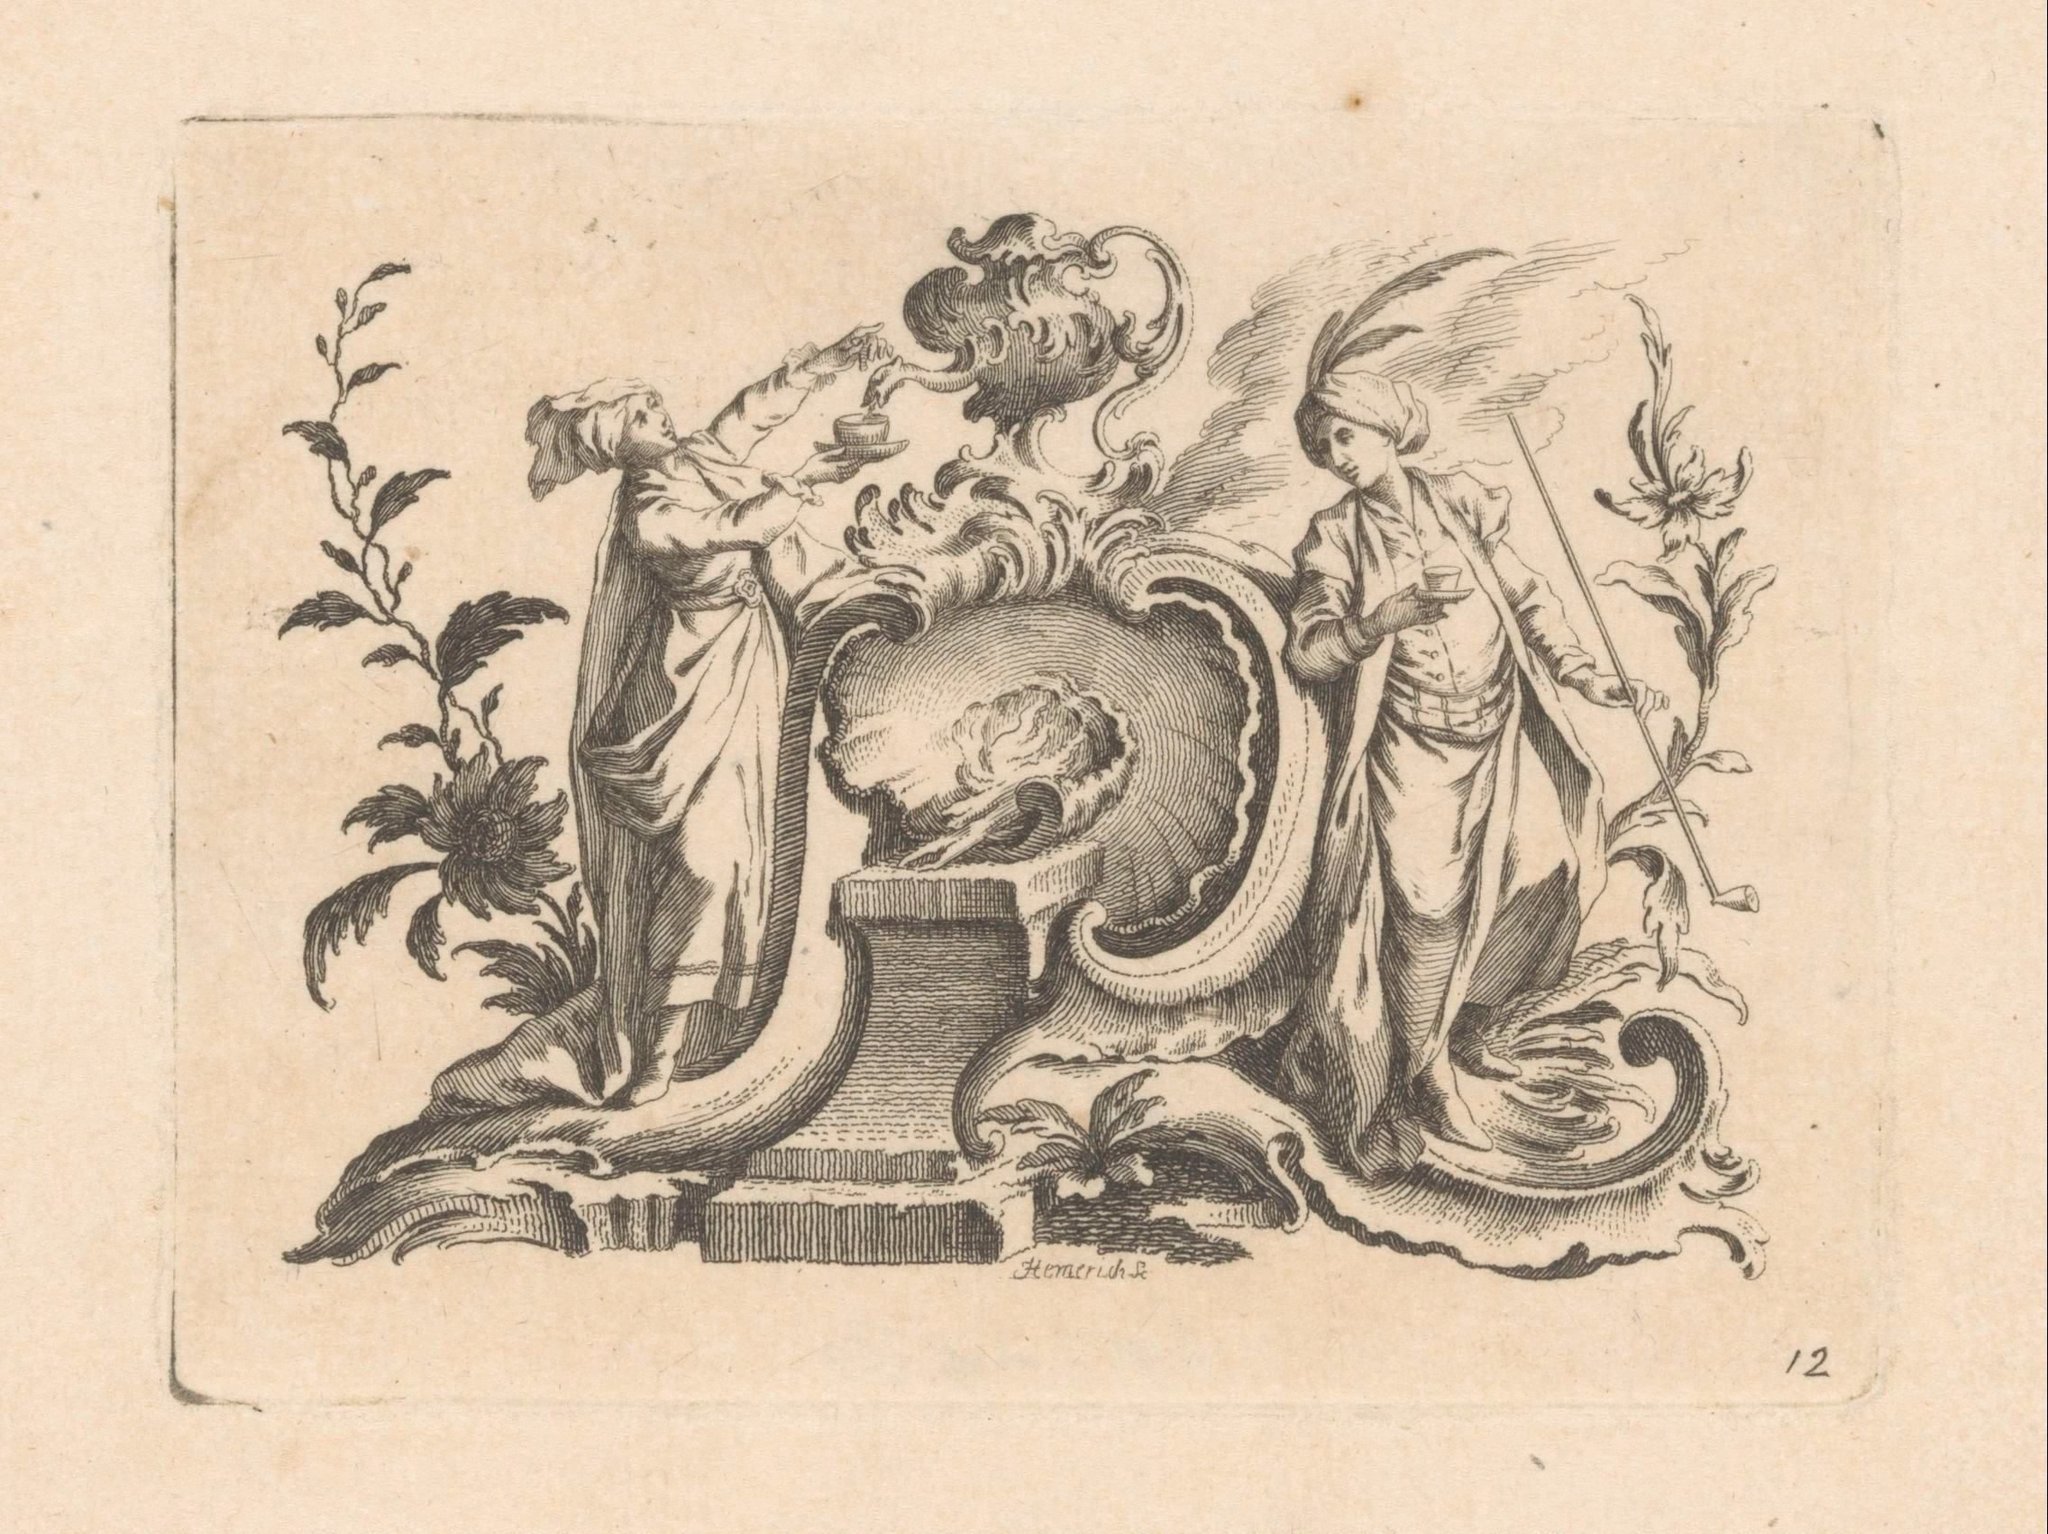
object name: ornament print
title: Man en vrouw drinken thee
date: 1731-1780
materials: paper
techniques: engraving, etching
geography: london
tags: cup of tea (+ taking (particular) foodstuffs: eating, drinking, smoking, chewing, etc.)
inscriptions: collector's mark: Lugt 2228, collector's mark: Lugt 2760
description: In een landschap met een rocaille ornament staat rechts een man met een tulband met een kop thee en een lange pijp in zijn hand. Links schenkt een vrouw een kop thee in.